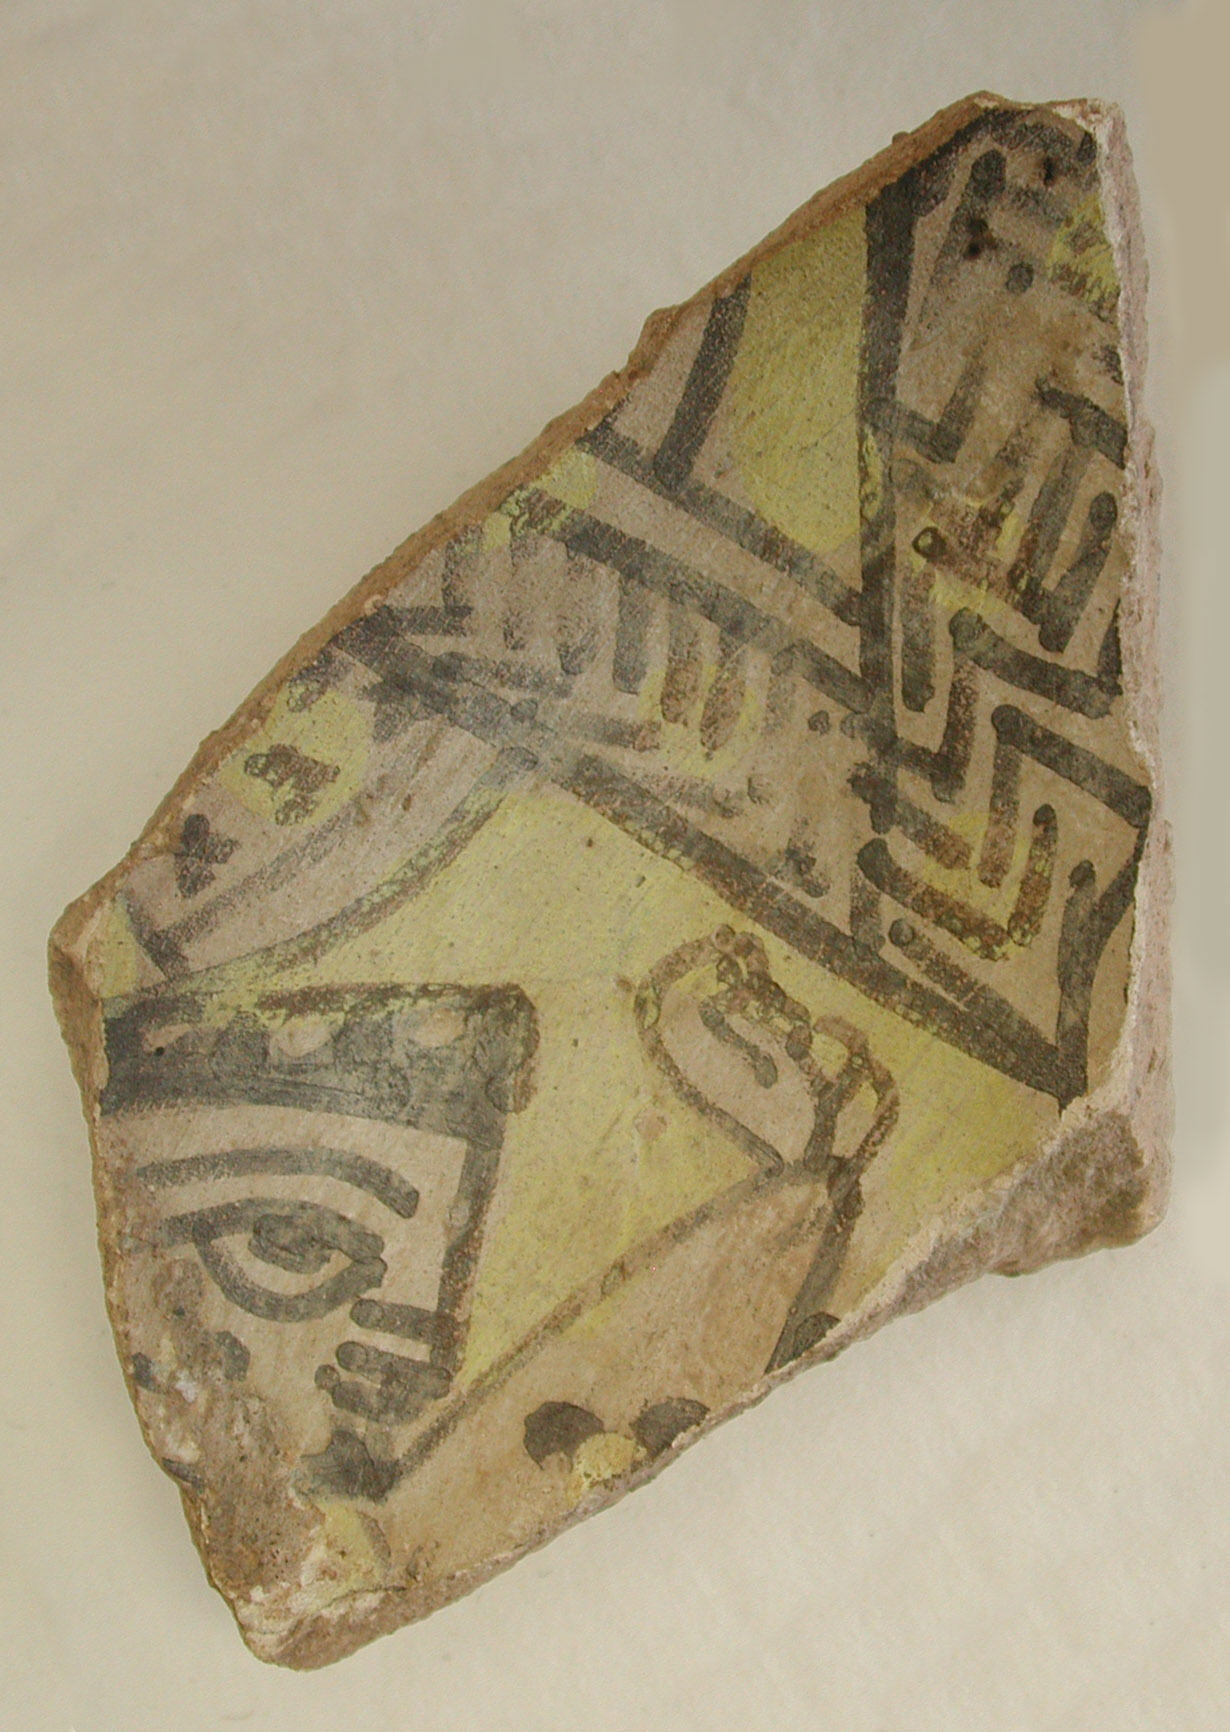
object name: painted plaster and ceramic fragment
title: Painted Plaster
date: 1101-1200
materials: plaster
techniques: painting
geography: iran